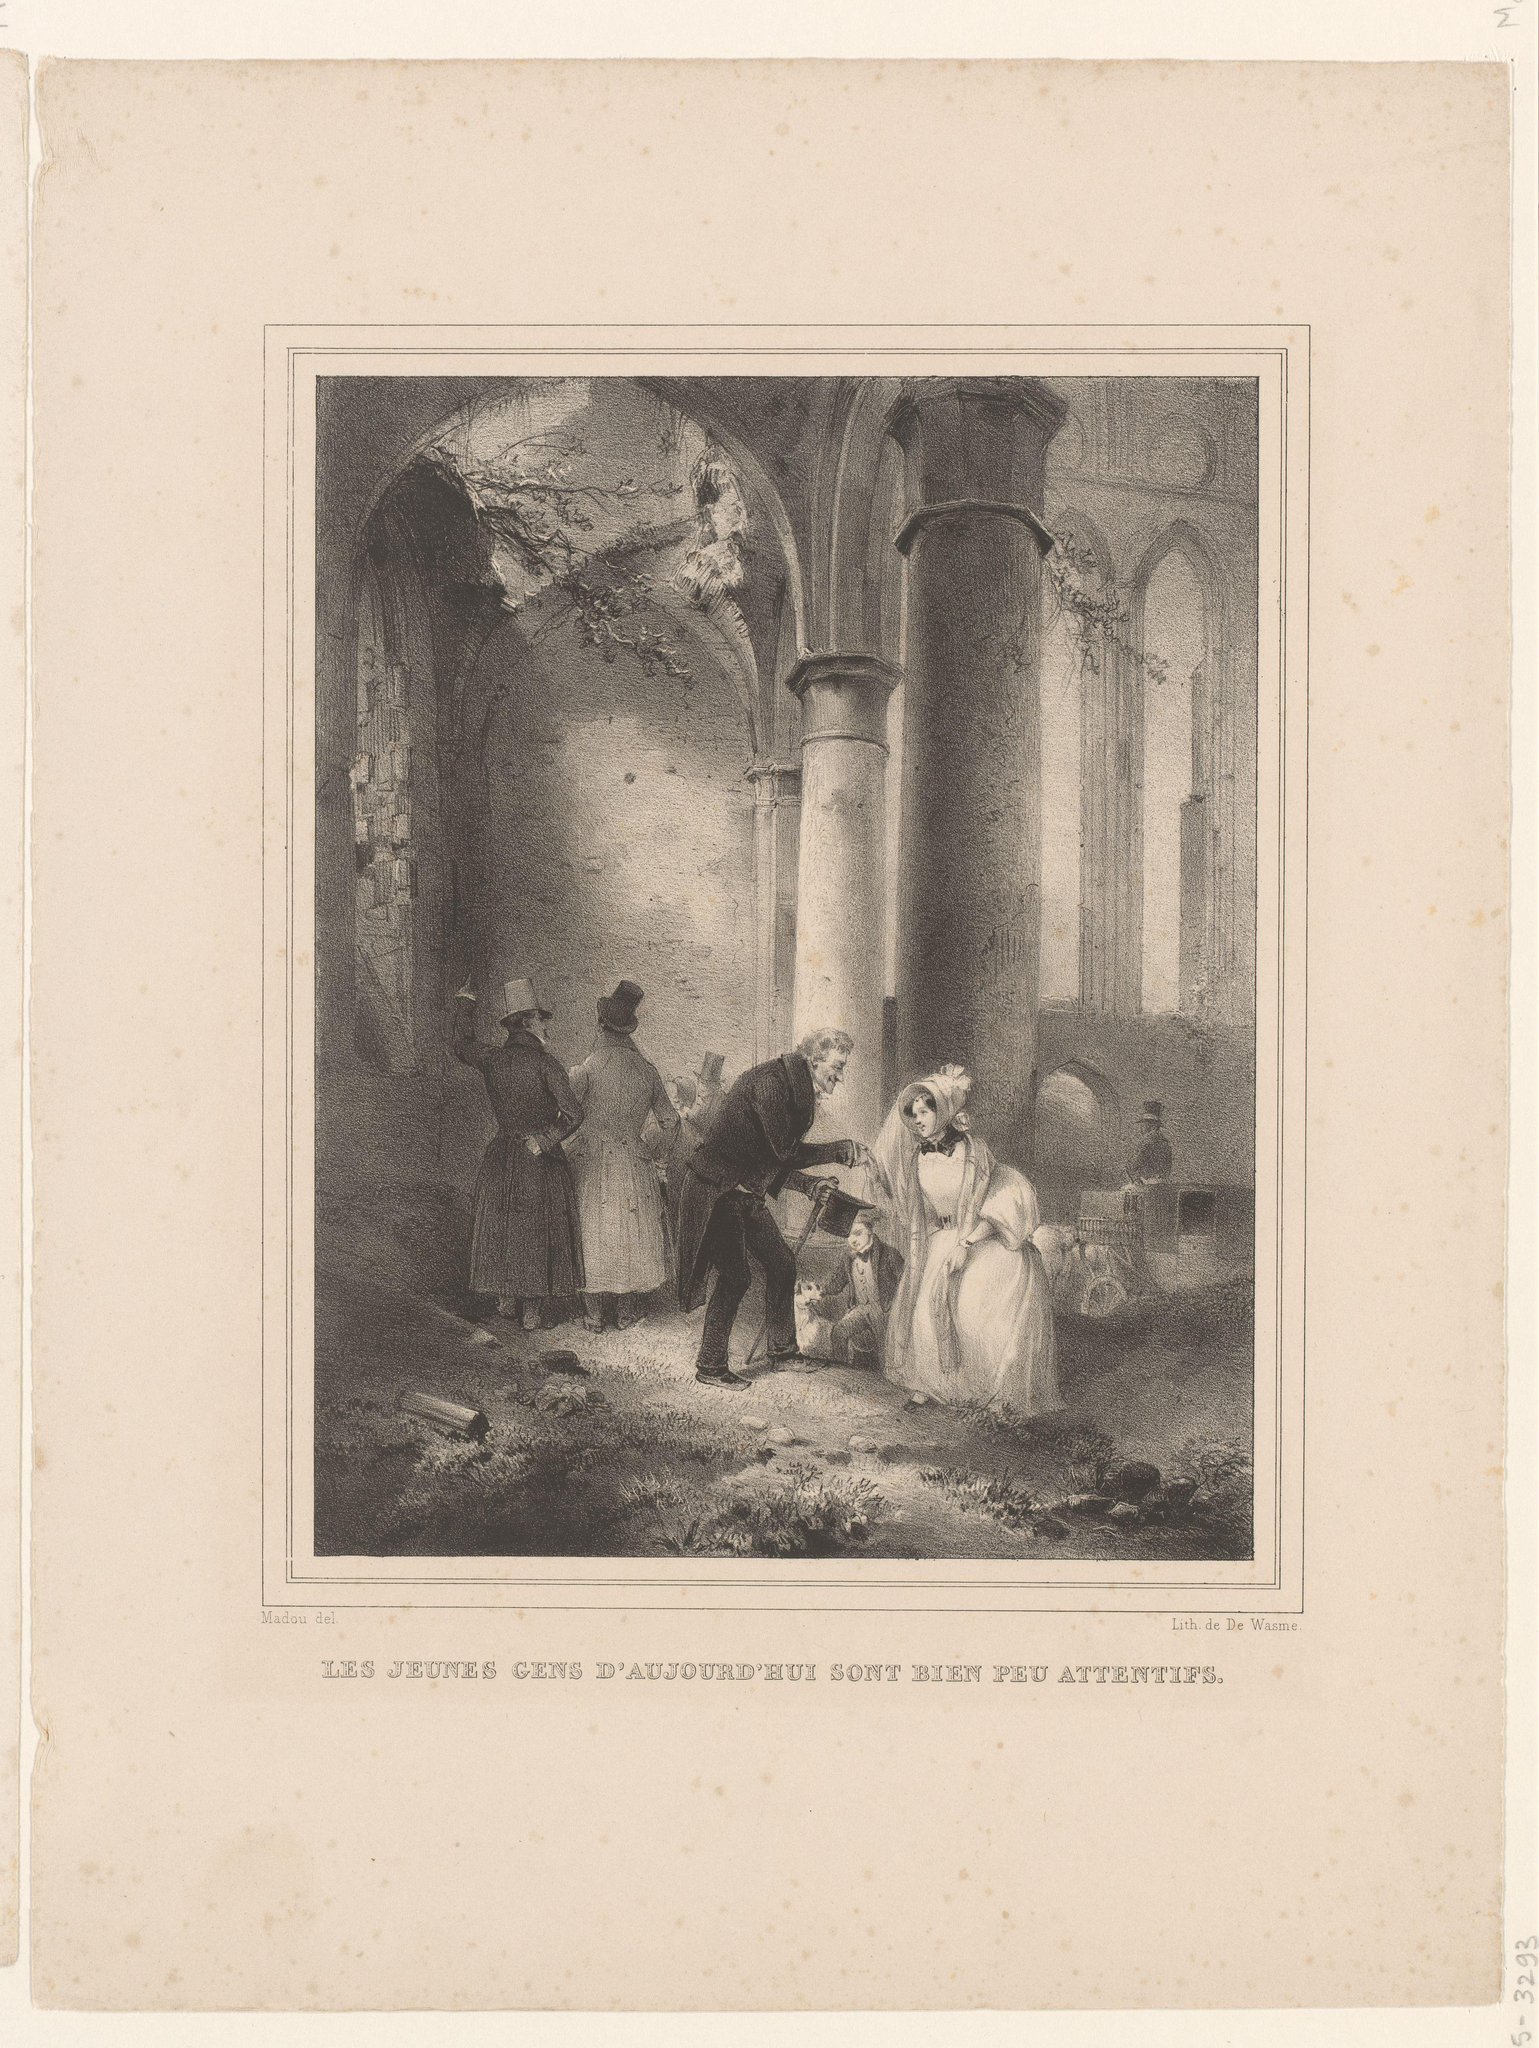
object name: print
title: Twaalf genretaferelen door Jean Baptiste Madou en Théodore Fourmois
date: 1834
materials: paper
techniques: lithograph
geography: brussels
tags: ruin of church, monastery, etc., landscape with ruins (+ city(-scape) with figures, staffage)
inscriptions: collector's mark: Lugt 2228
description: Prent behoort tot een serie met twaalf genretaferelen vervaardigd door Madou en Fourmois. Vier prenten zijn enkel door Madou vervaardigd en de overige prenten door Madou en Fourmois samen. Madou vervaardigde de figuren en Fourmois het landschap.